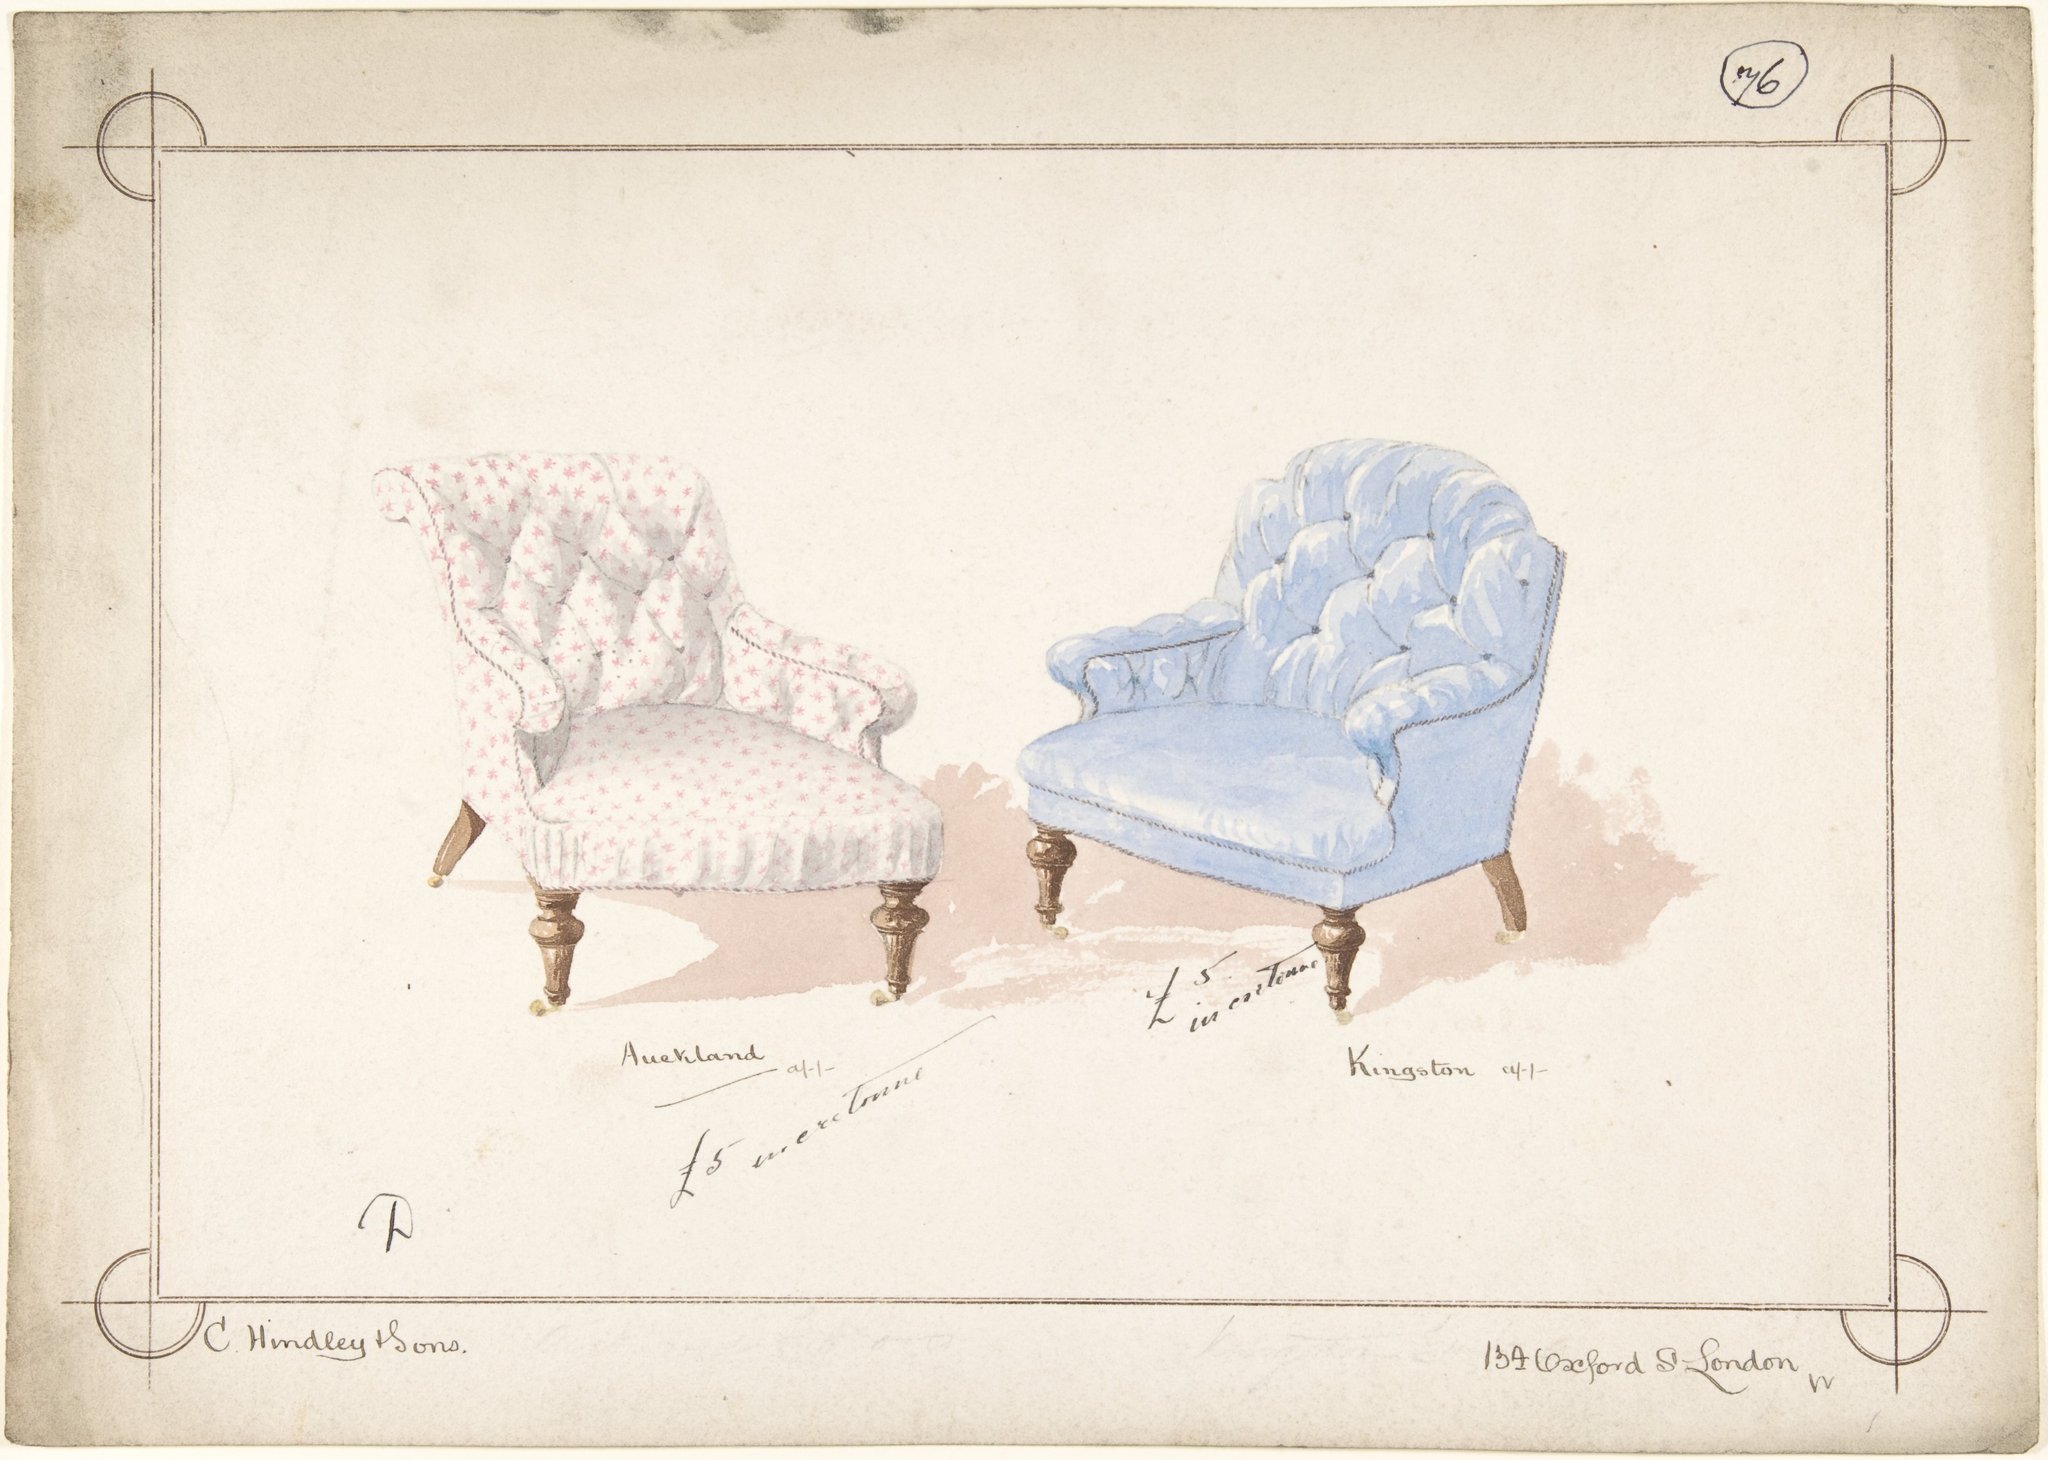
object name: drawing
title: Designs for Two Chairs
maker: charles hindley and sons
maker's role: artist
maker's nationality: british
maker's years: 1841-1917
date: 1841-1884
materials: graphite, watercolor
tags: chairs